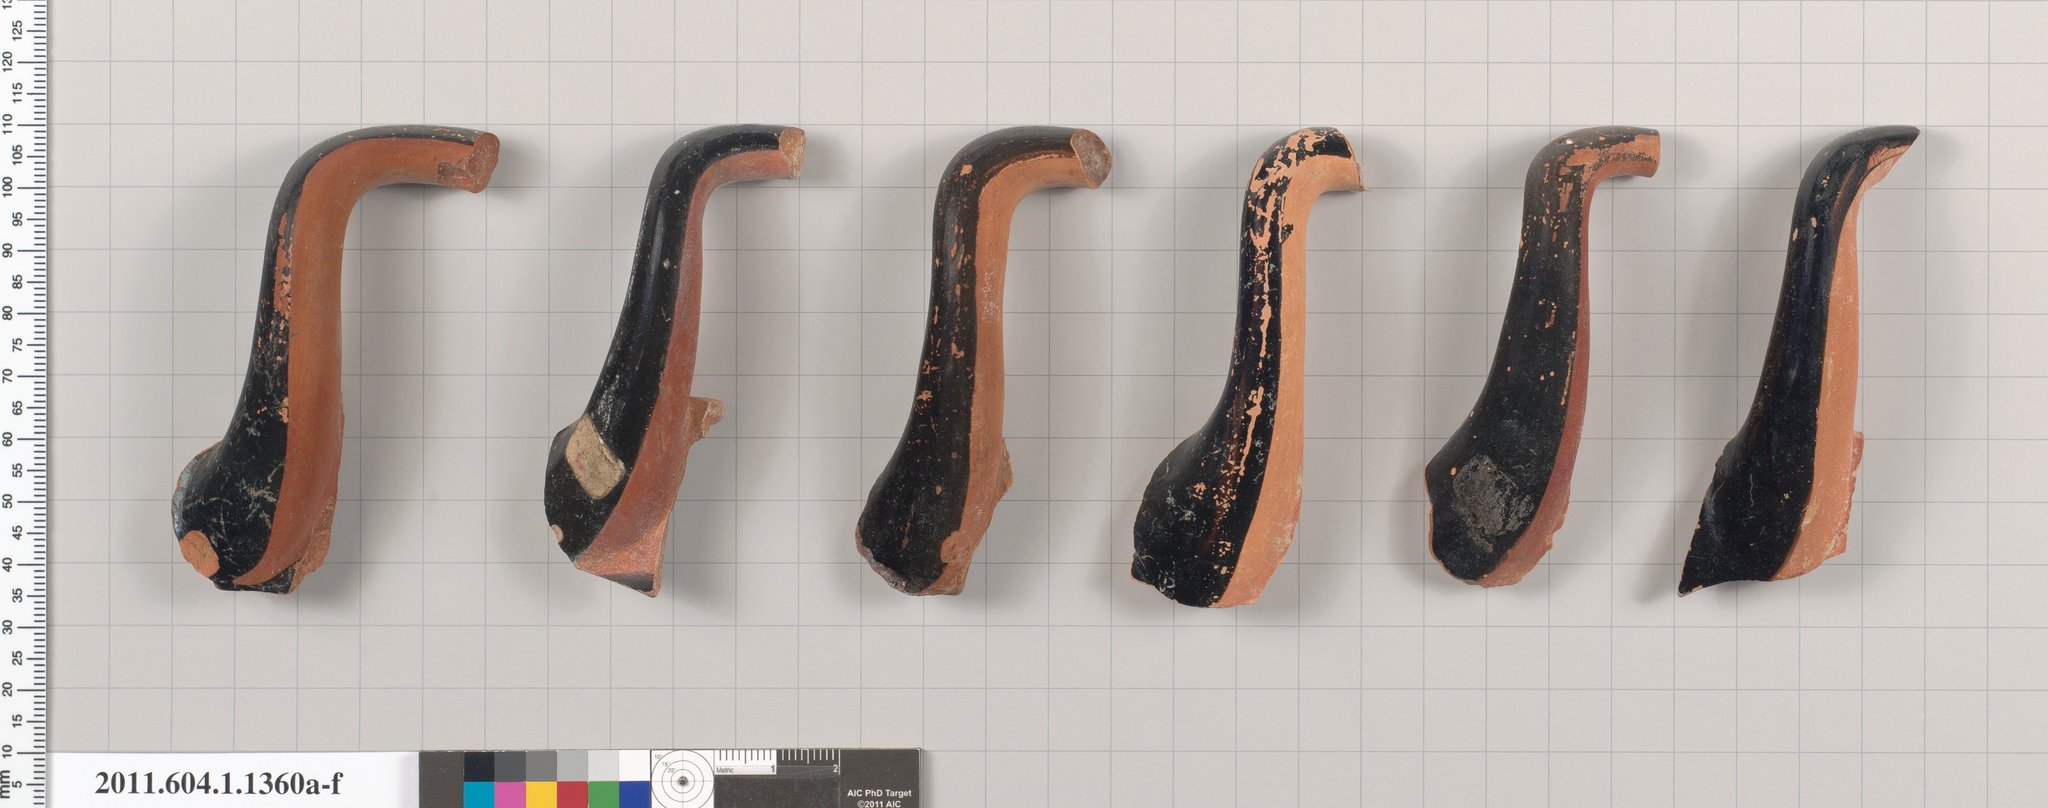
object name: kylix fragment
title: Terracotta fragments of kylikes (drinking cups)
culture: greek, attic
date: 500-401 BCE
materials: terracotta